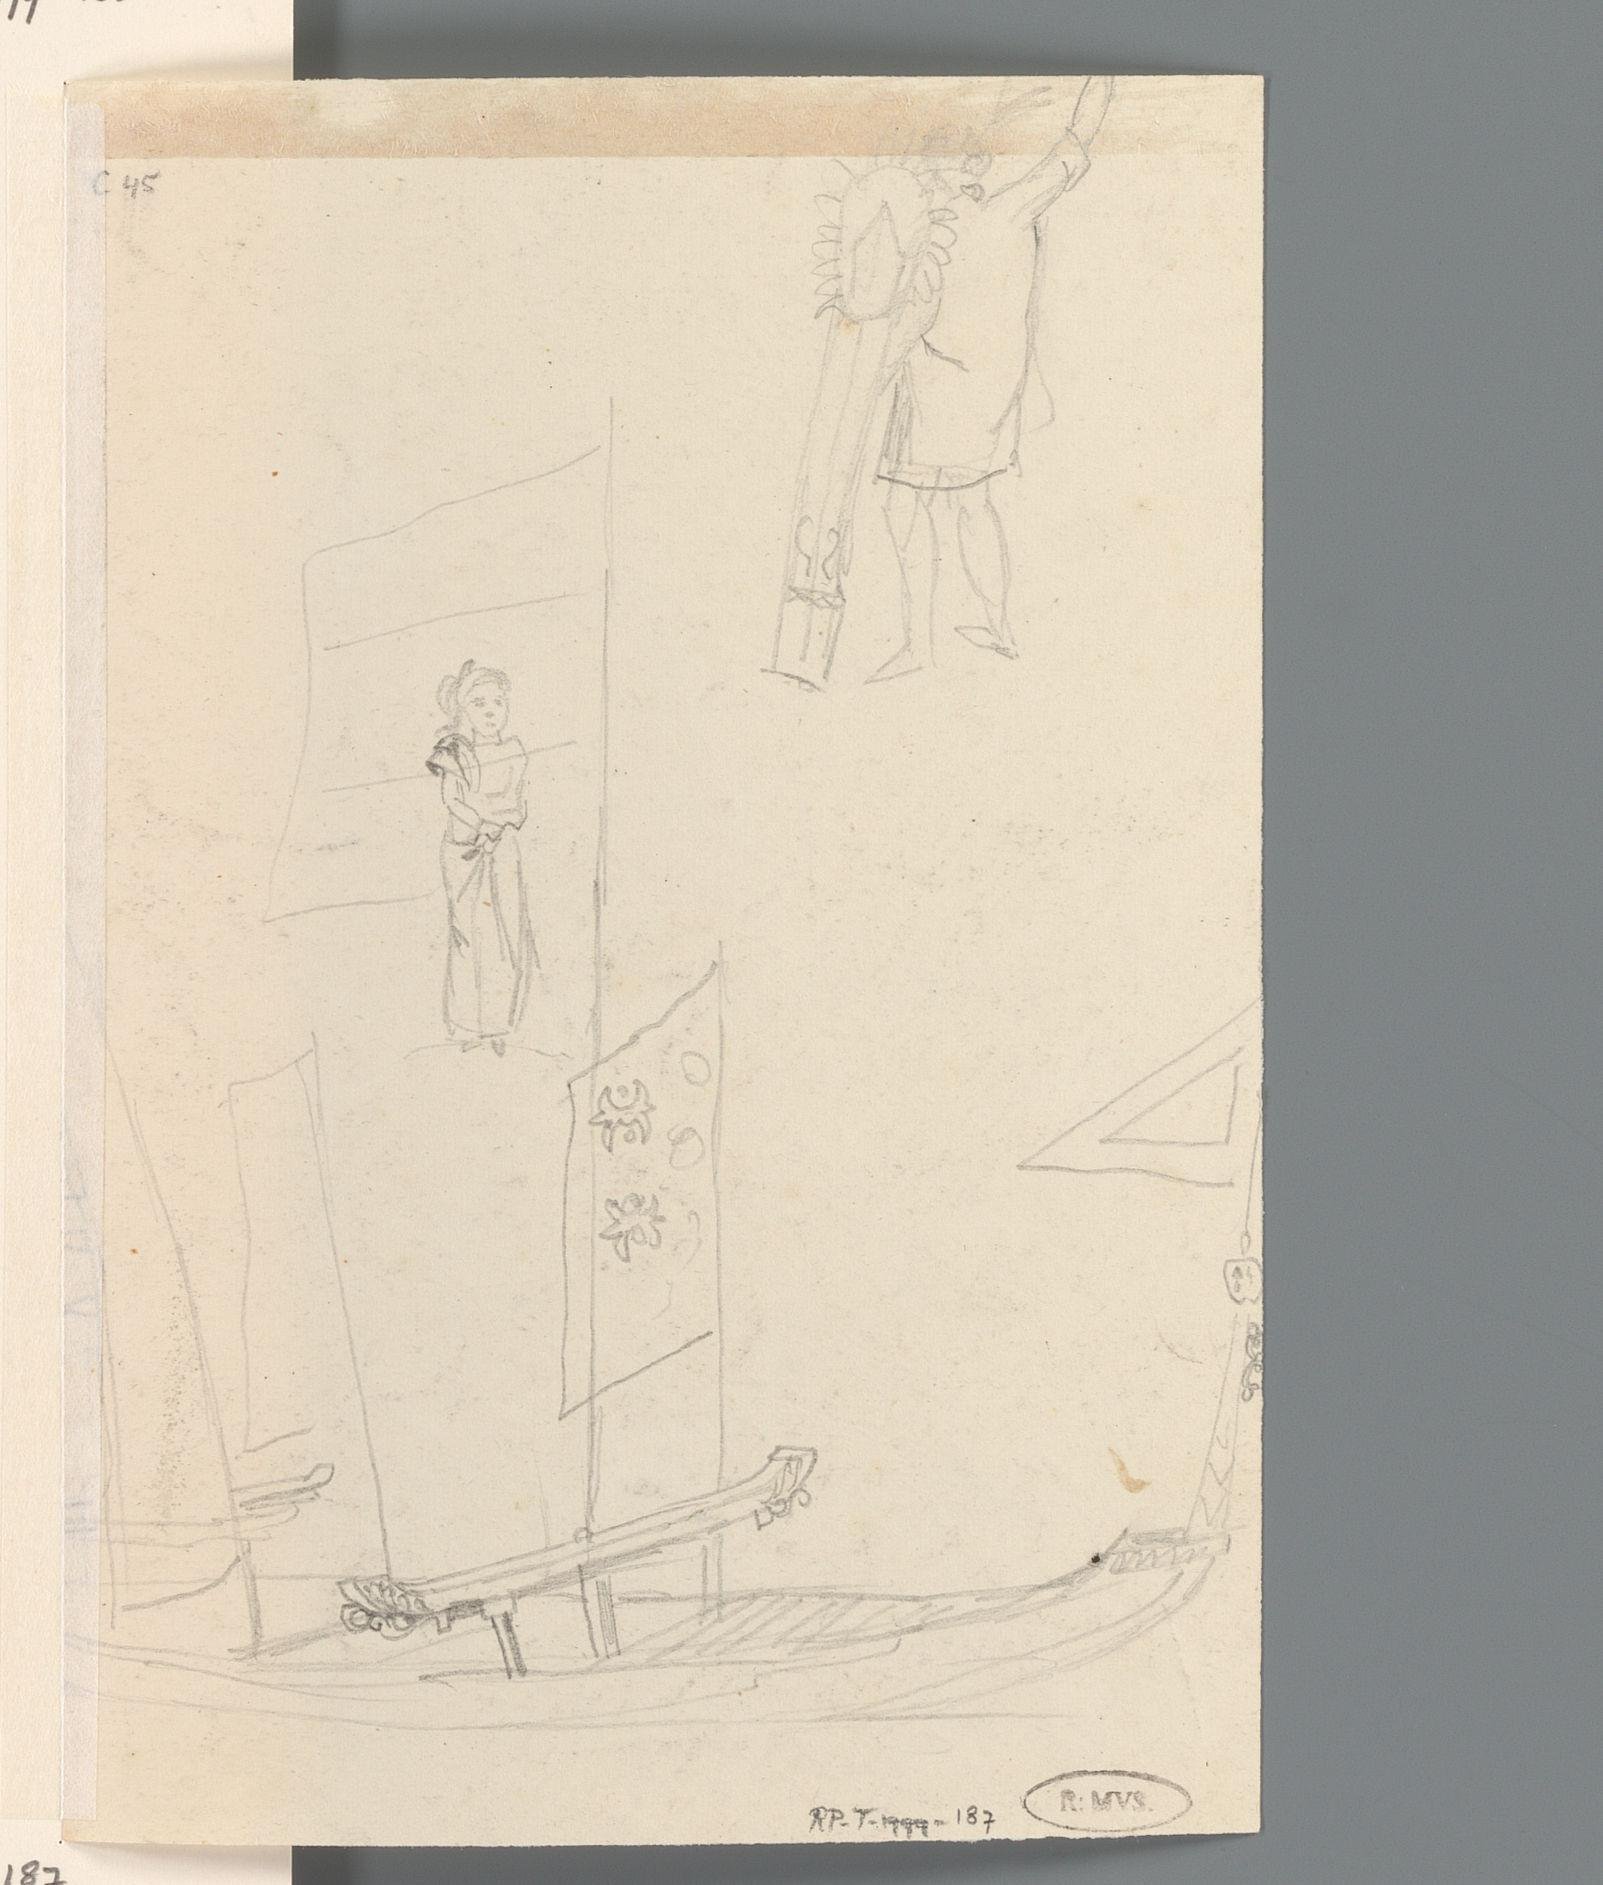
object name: drawing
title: Detail van vaartuig, vrouw en een man met een schild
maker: adrianus johannes bik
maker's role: draughtsman, print maker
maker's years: 1790-1872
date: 1824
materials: paper, pencil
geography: south moluccas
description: artikel over deze collectie in Bulletin van het Rijksmuseum 49 [2001], nr. 4, pp.343 e.v.